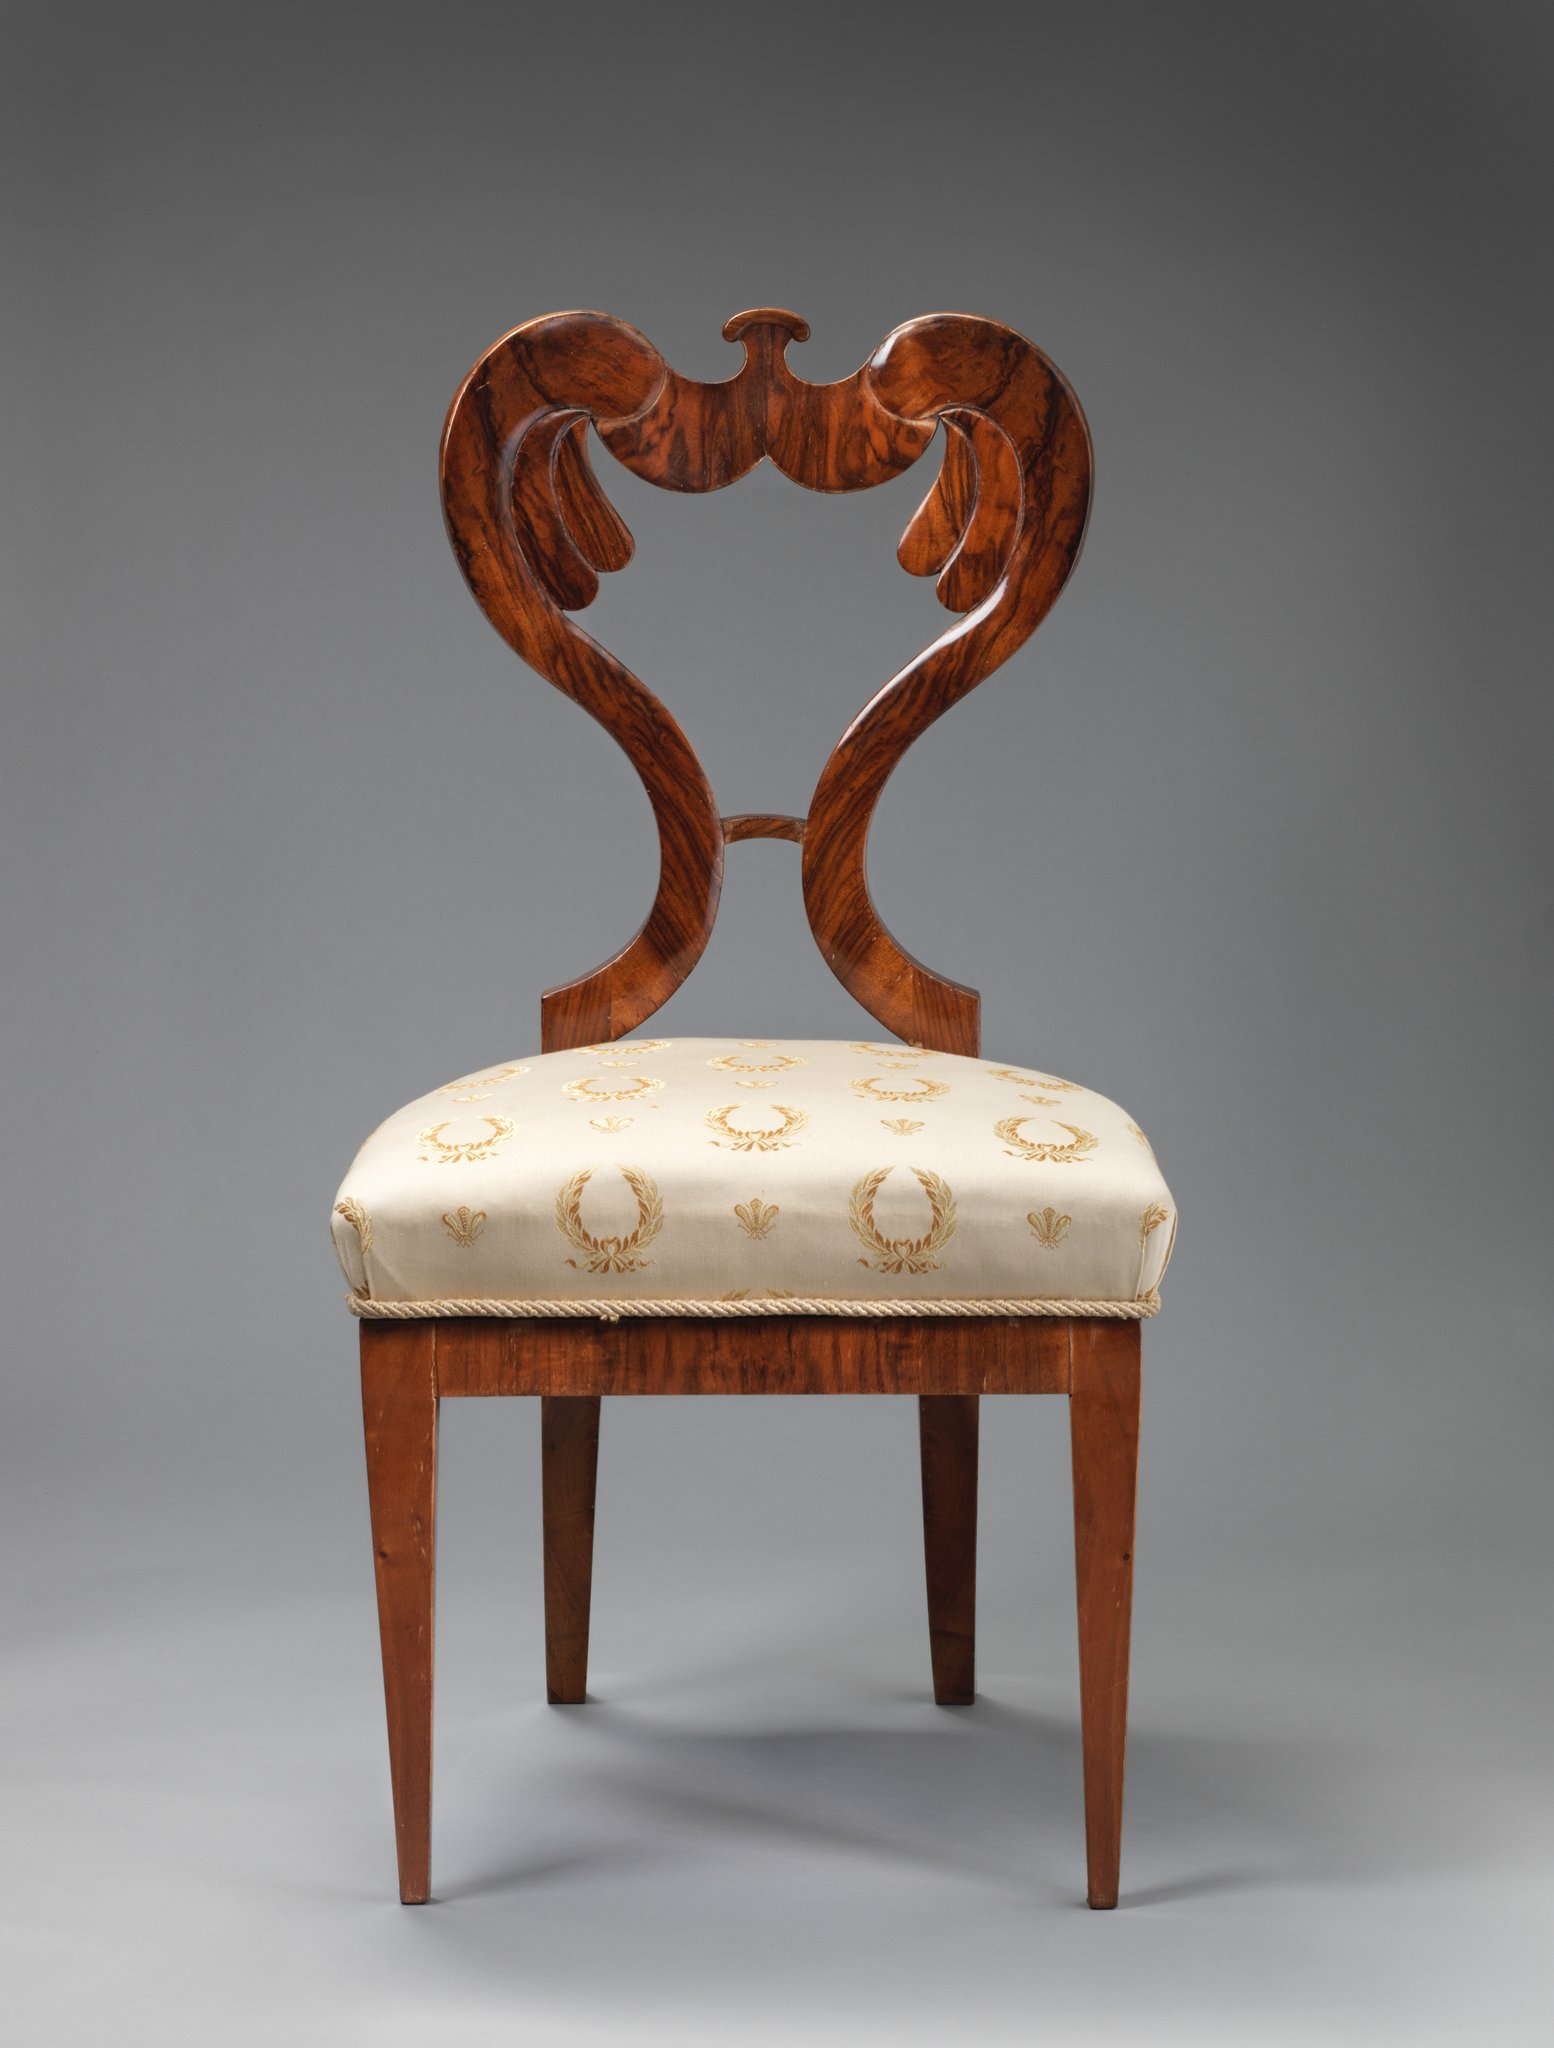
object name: chair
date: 1830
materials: wood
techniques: veneering